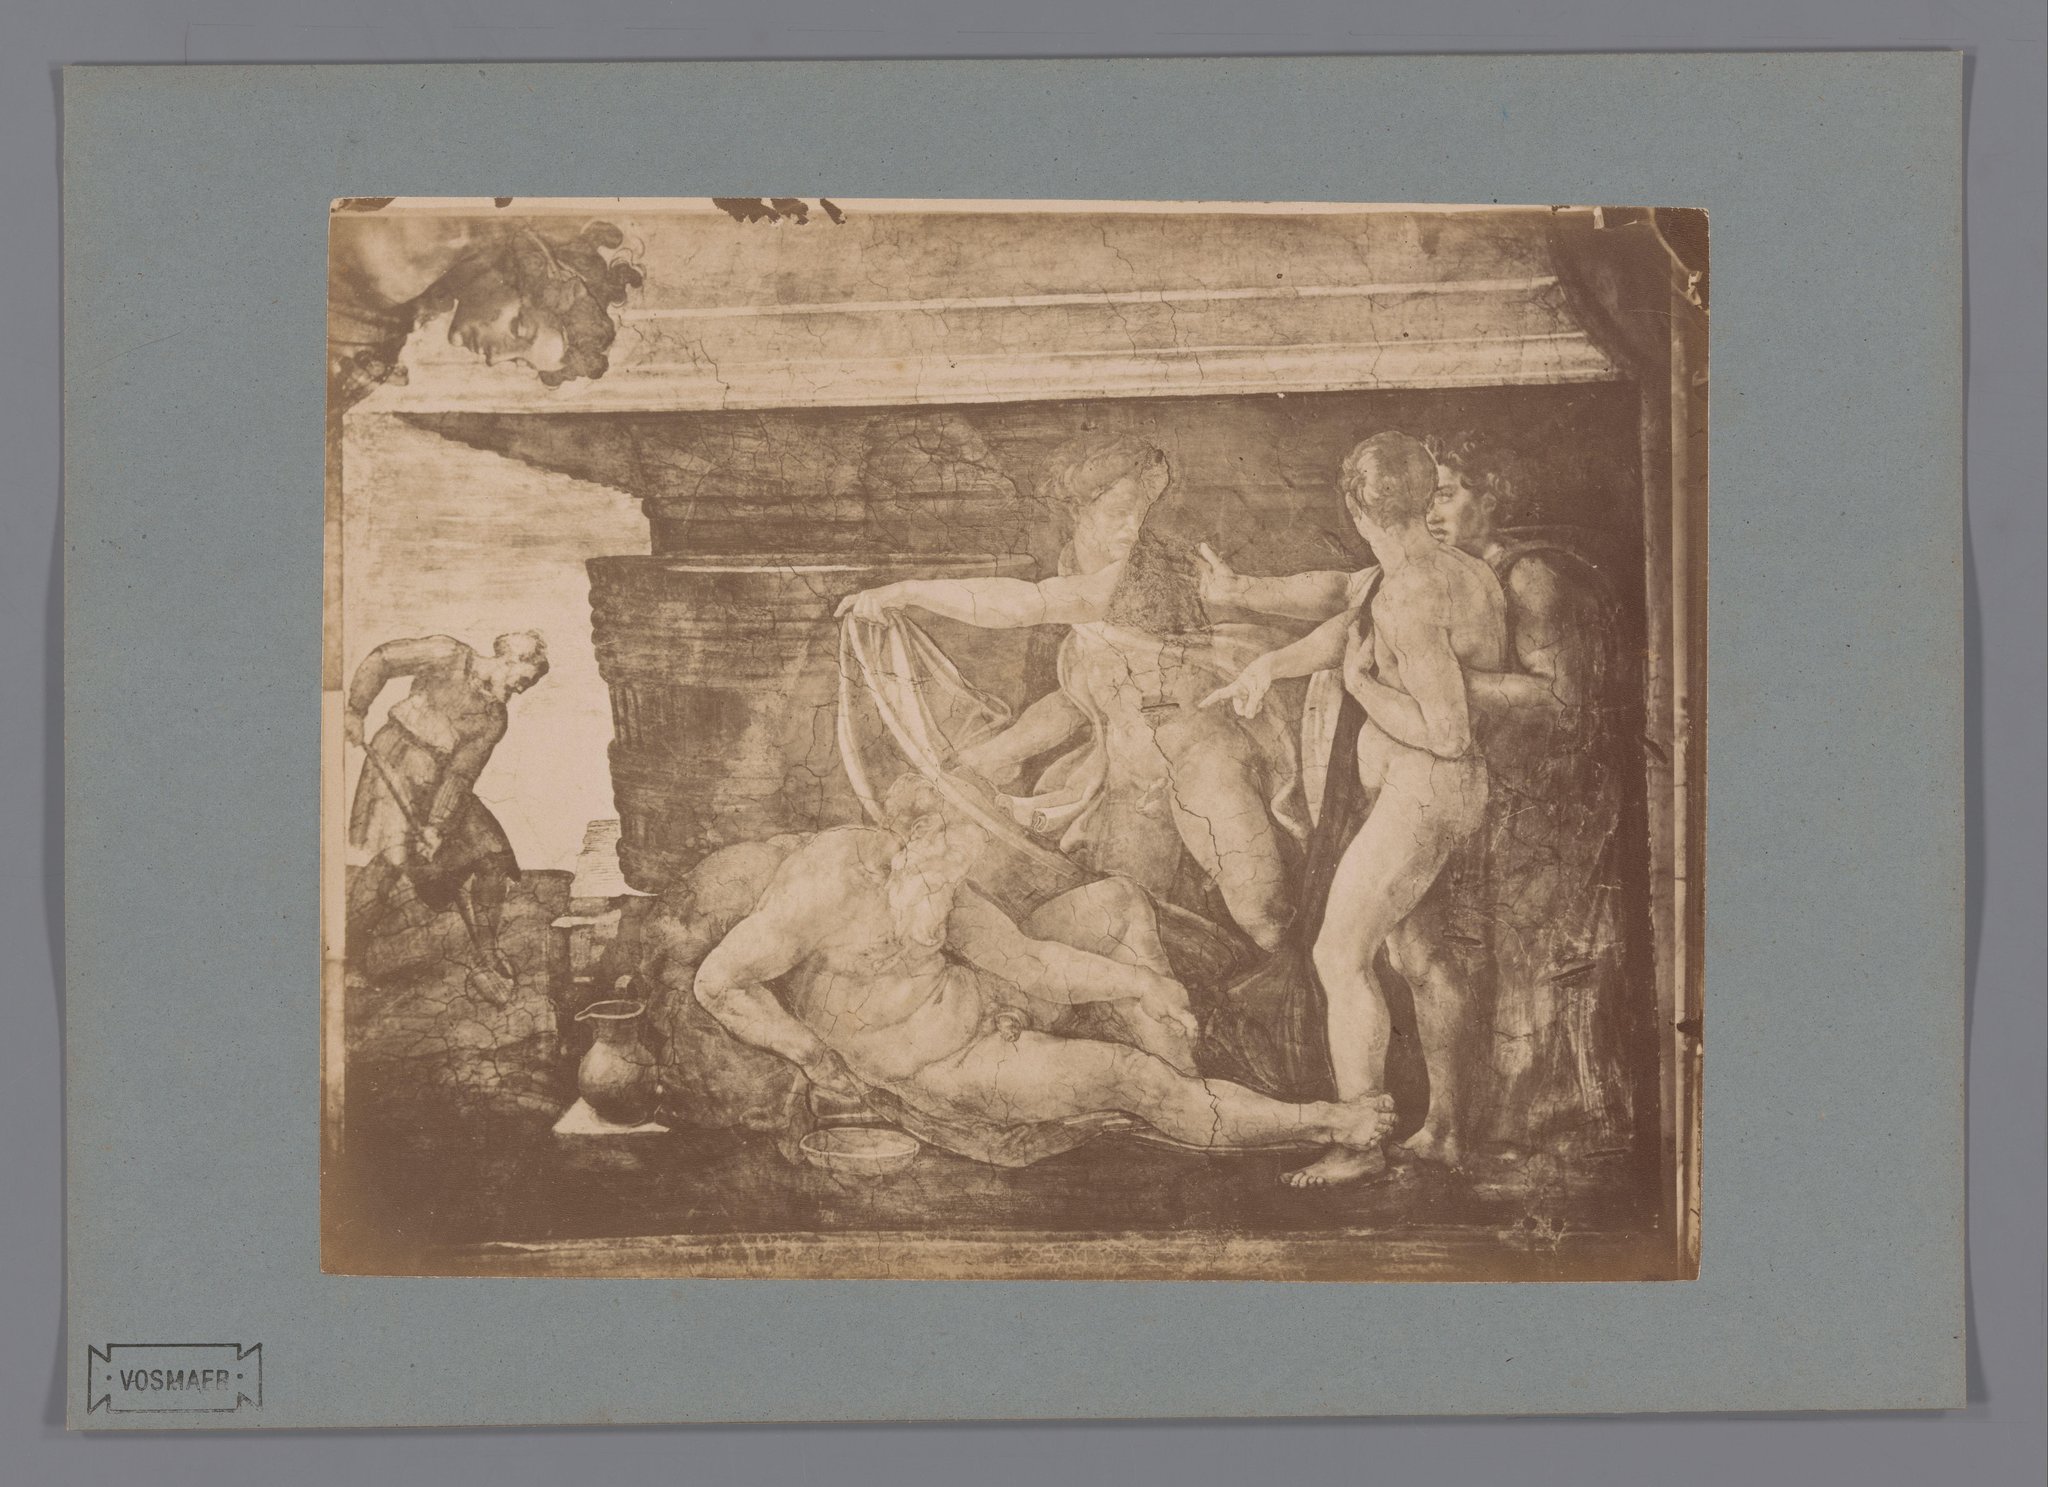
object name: photograph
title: Fotoreproductie van het fresco De dronkenschap van Noach door Michelangelo in de Sixtijnse kapel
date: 1851-1900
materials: cardboard, paper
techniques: albumen print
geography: vatican city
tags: the drunkenness of noah, picture, painting, wall-covering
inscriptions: collector's mark: ‘VOSMAER’